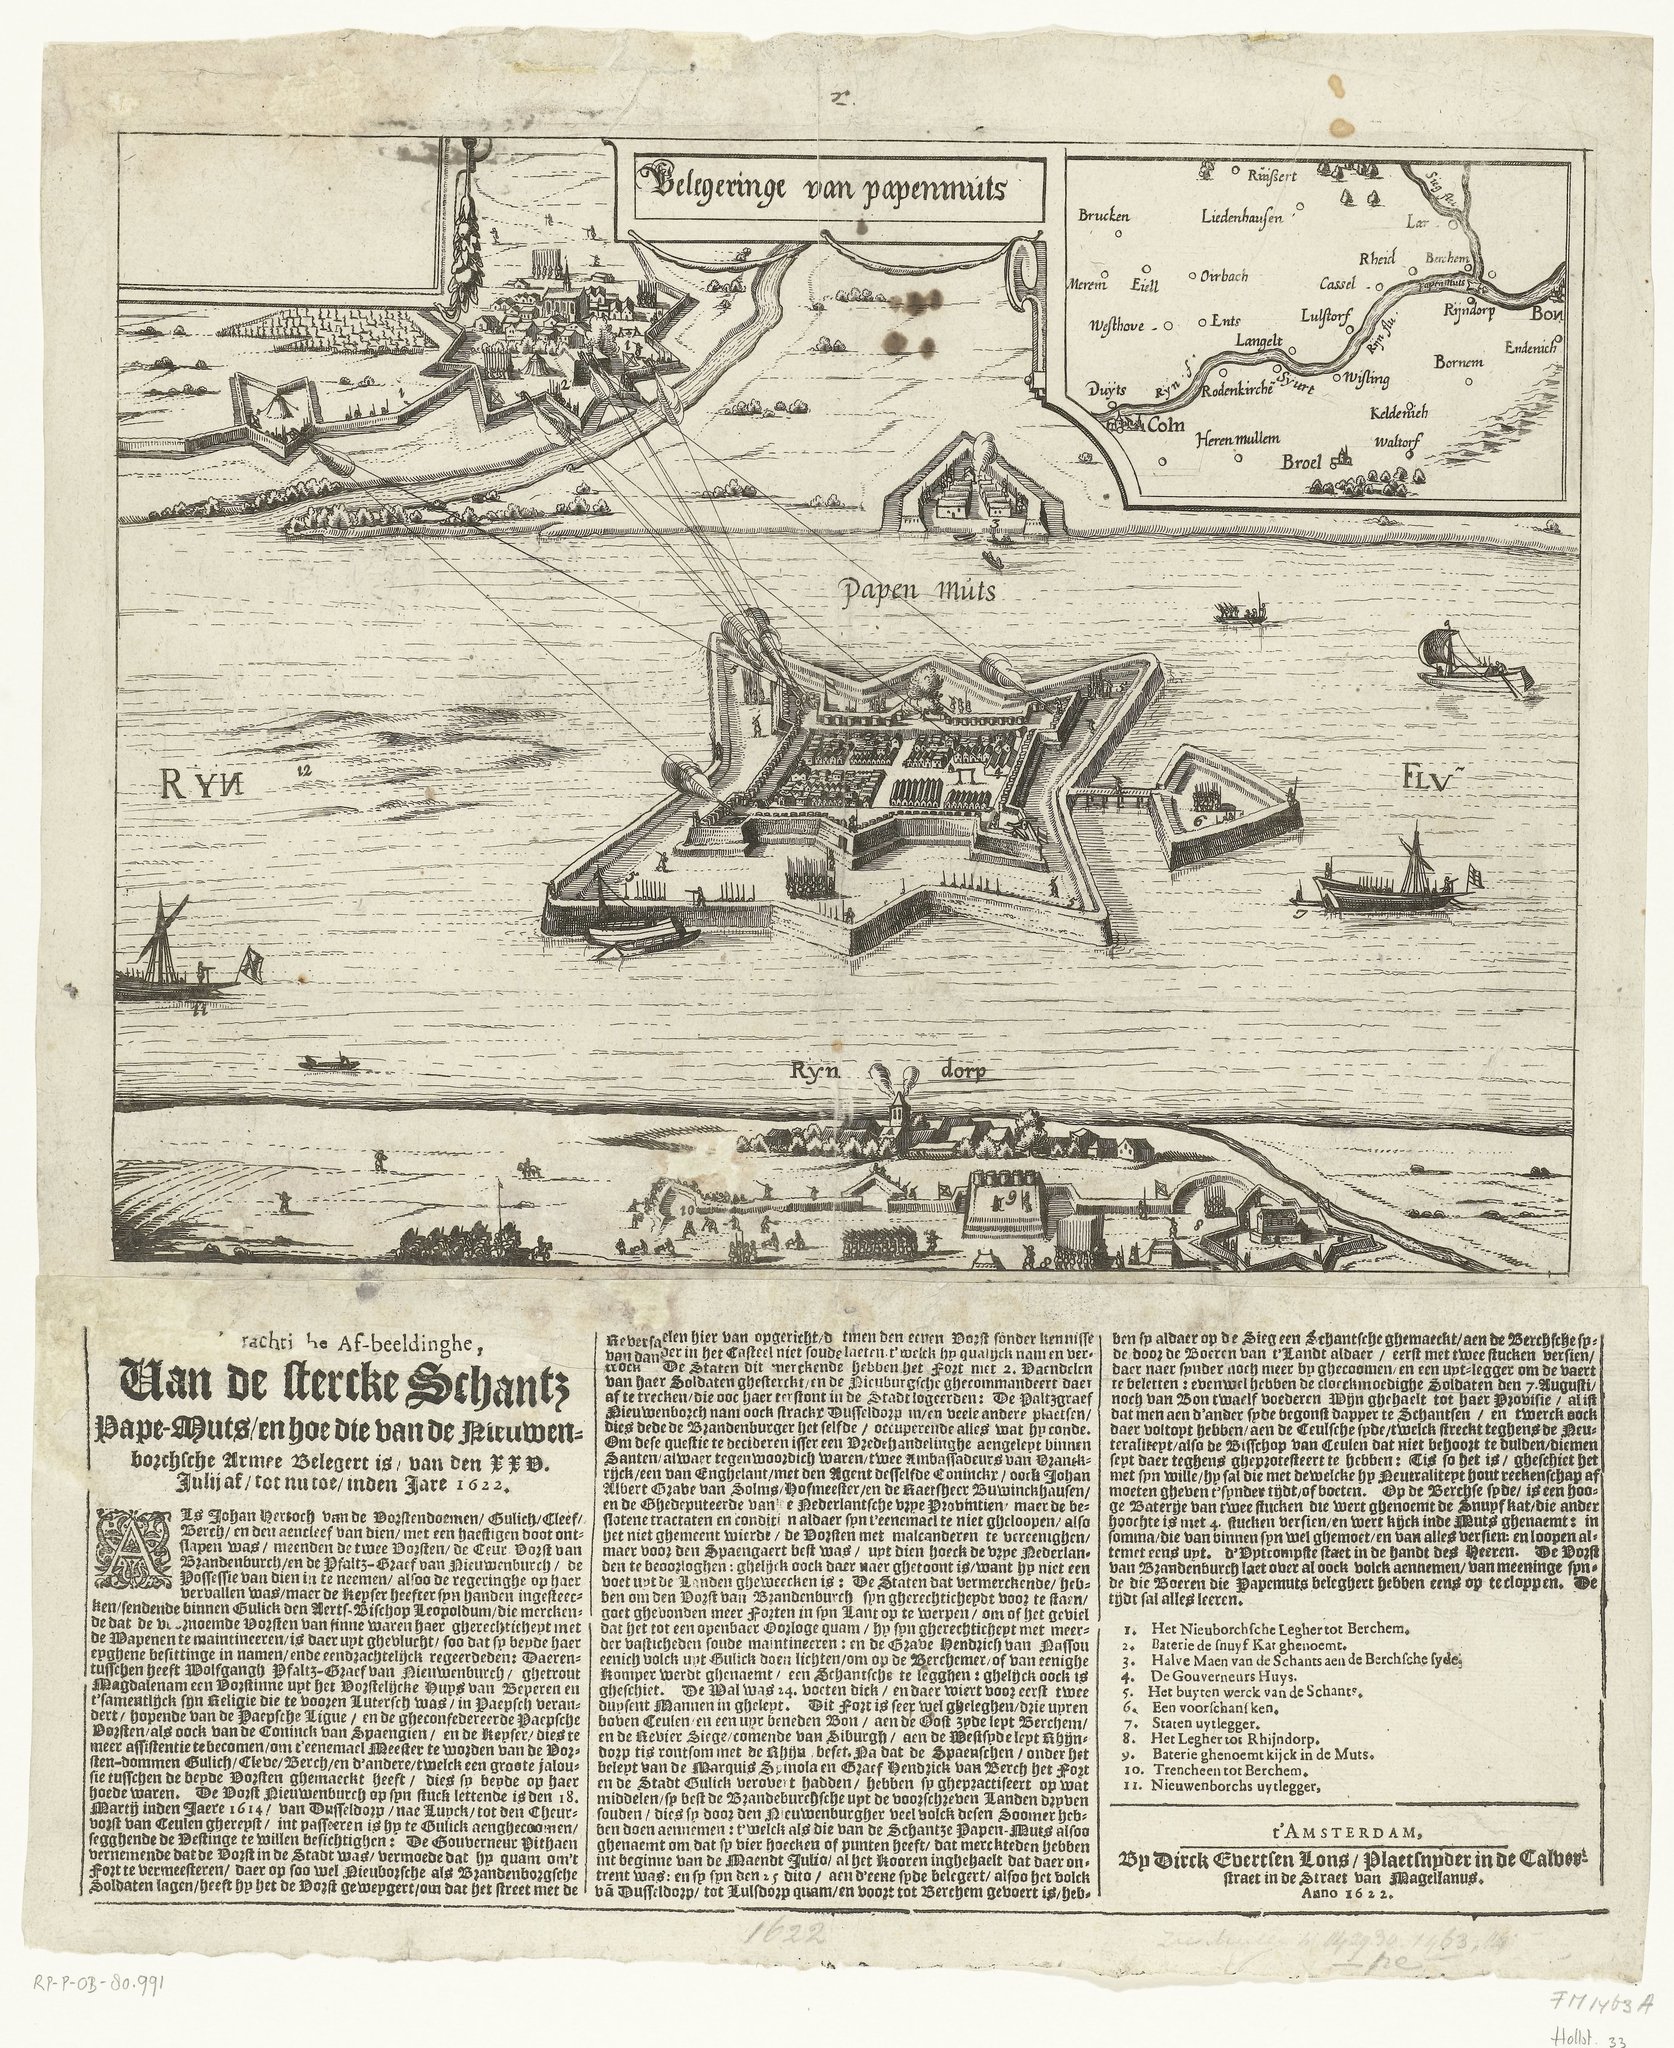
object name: print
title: Belegering van Schans Papenmuts, 1622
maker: dirk eversen lons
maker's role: print maker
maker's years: 1599-1686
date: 1622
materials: paper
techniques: etching, letterpress printing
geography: amsterdam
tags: wolfgang willem van de palts-neuburg, siege, position war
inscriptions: date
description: Belegering van Schans Papenmuts door de hertog van Neuburg voor de koning van Spanje, vanaf 25 juli 1622. Gezicht op het fort gelegen op een eiland in de Rijn en de beschietingen vanaf de overzijde. Bovenaan enkele cartouches met rechts het grotere gebied van Rijnland. Onder de plaat een beschrijving van de gebeurtenissen en de legenda 1-11 in 3 kolommen in het Nederlands.